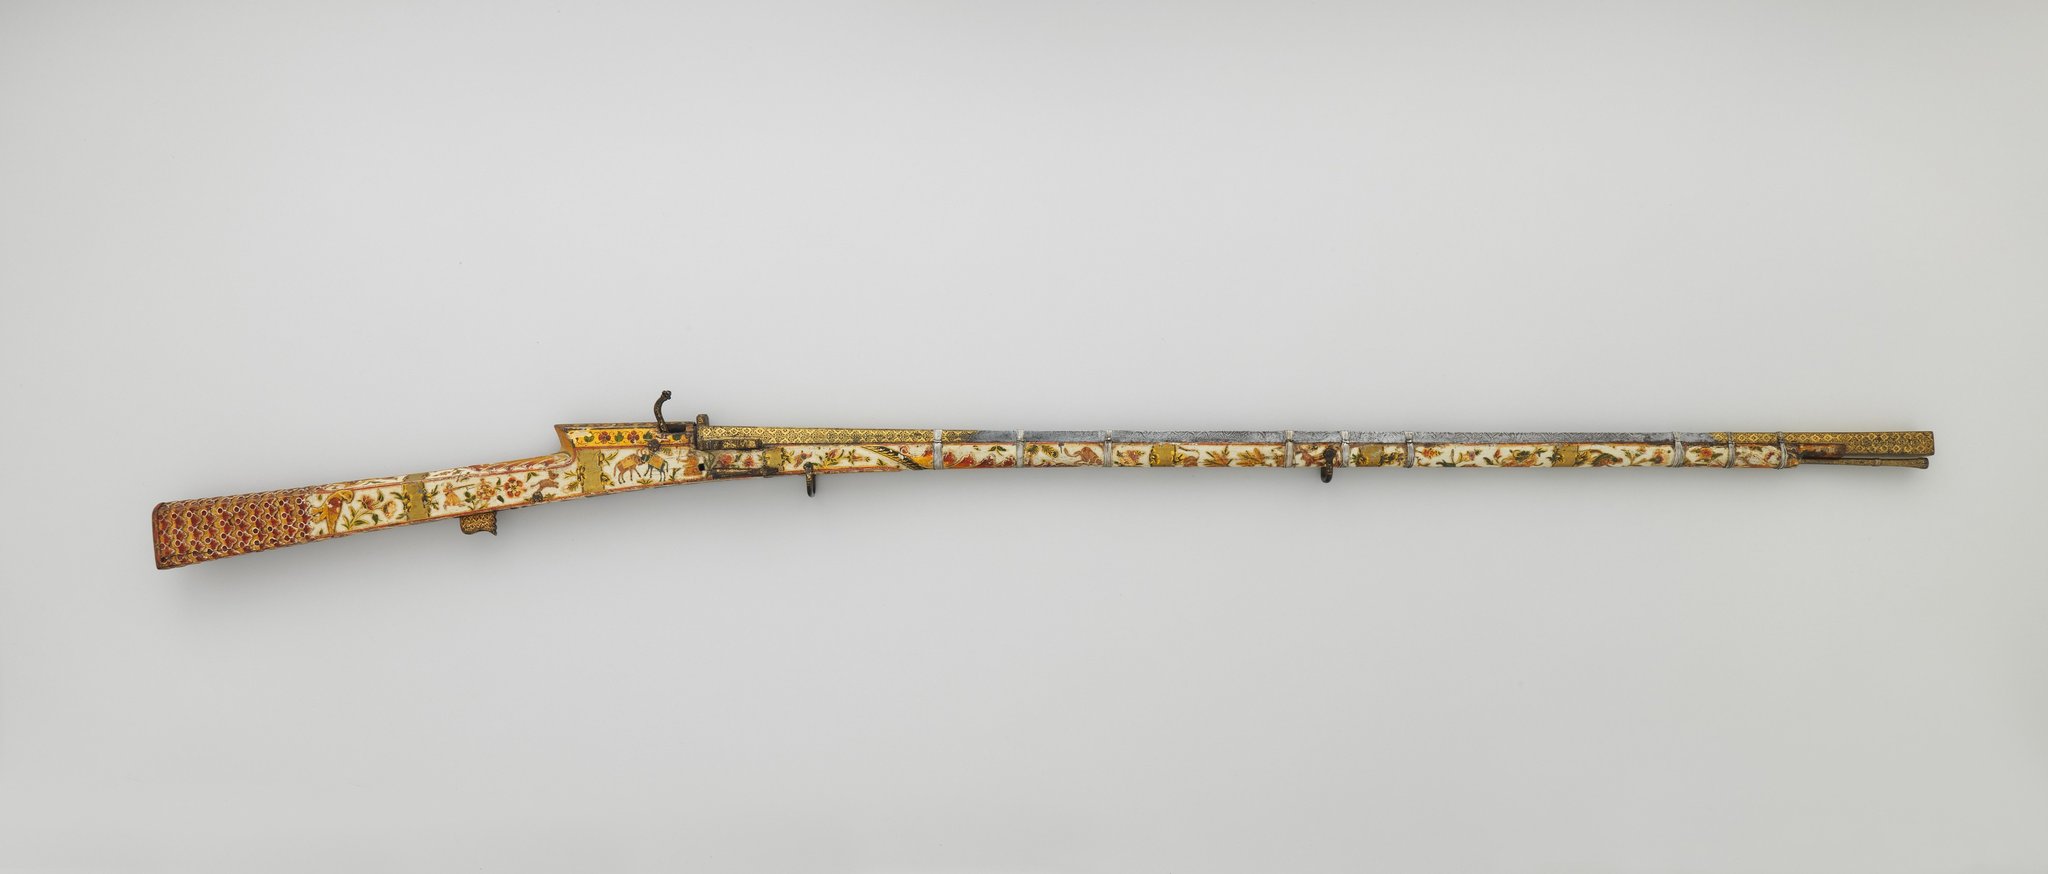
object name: matchlock gun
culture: indian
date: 1767-1833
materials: gold, pigment, silver, steel, wood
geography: india